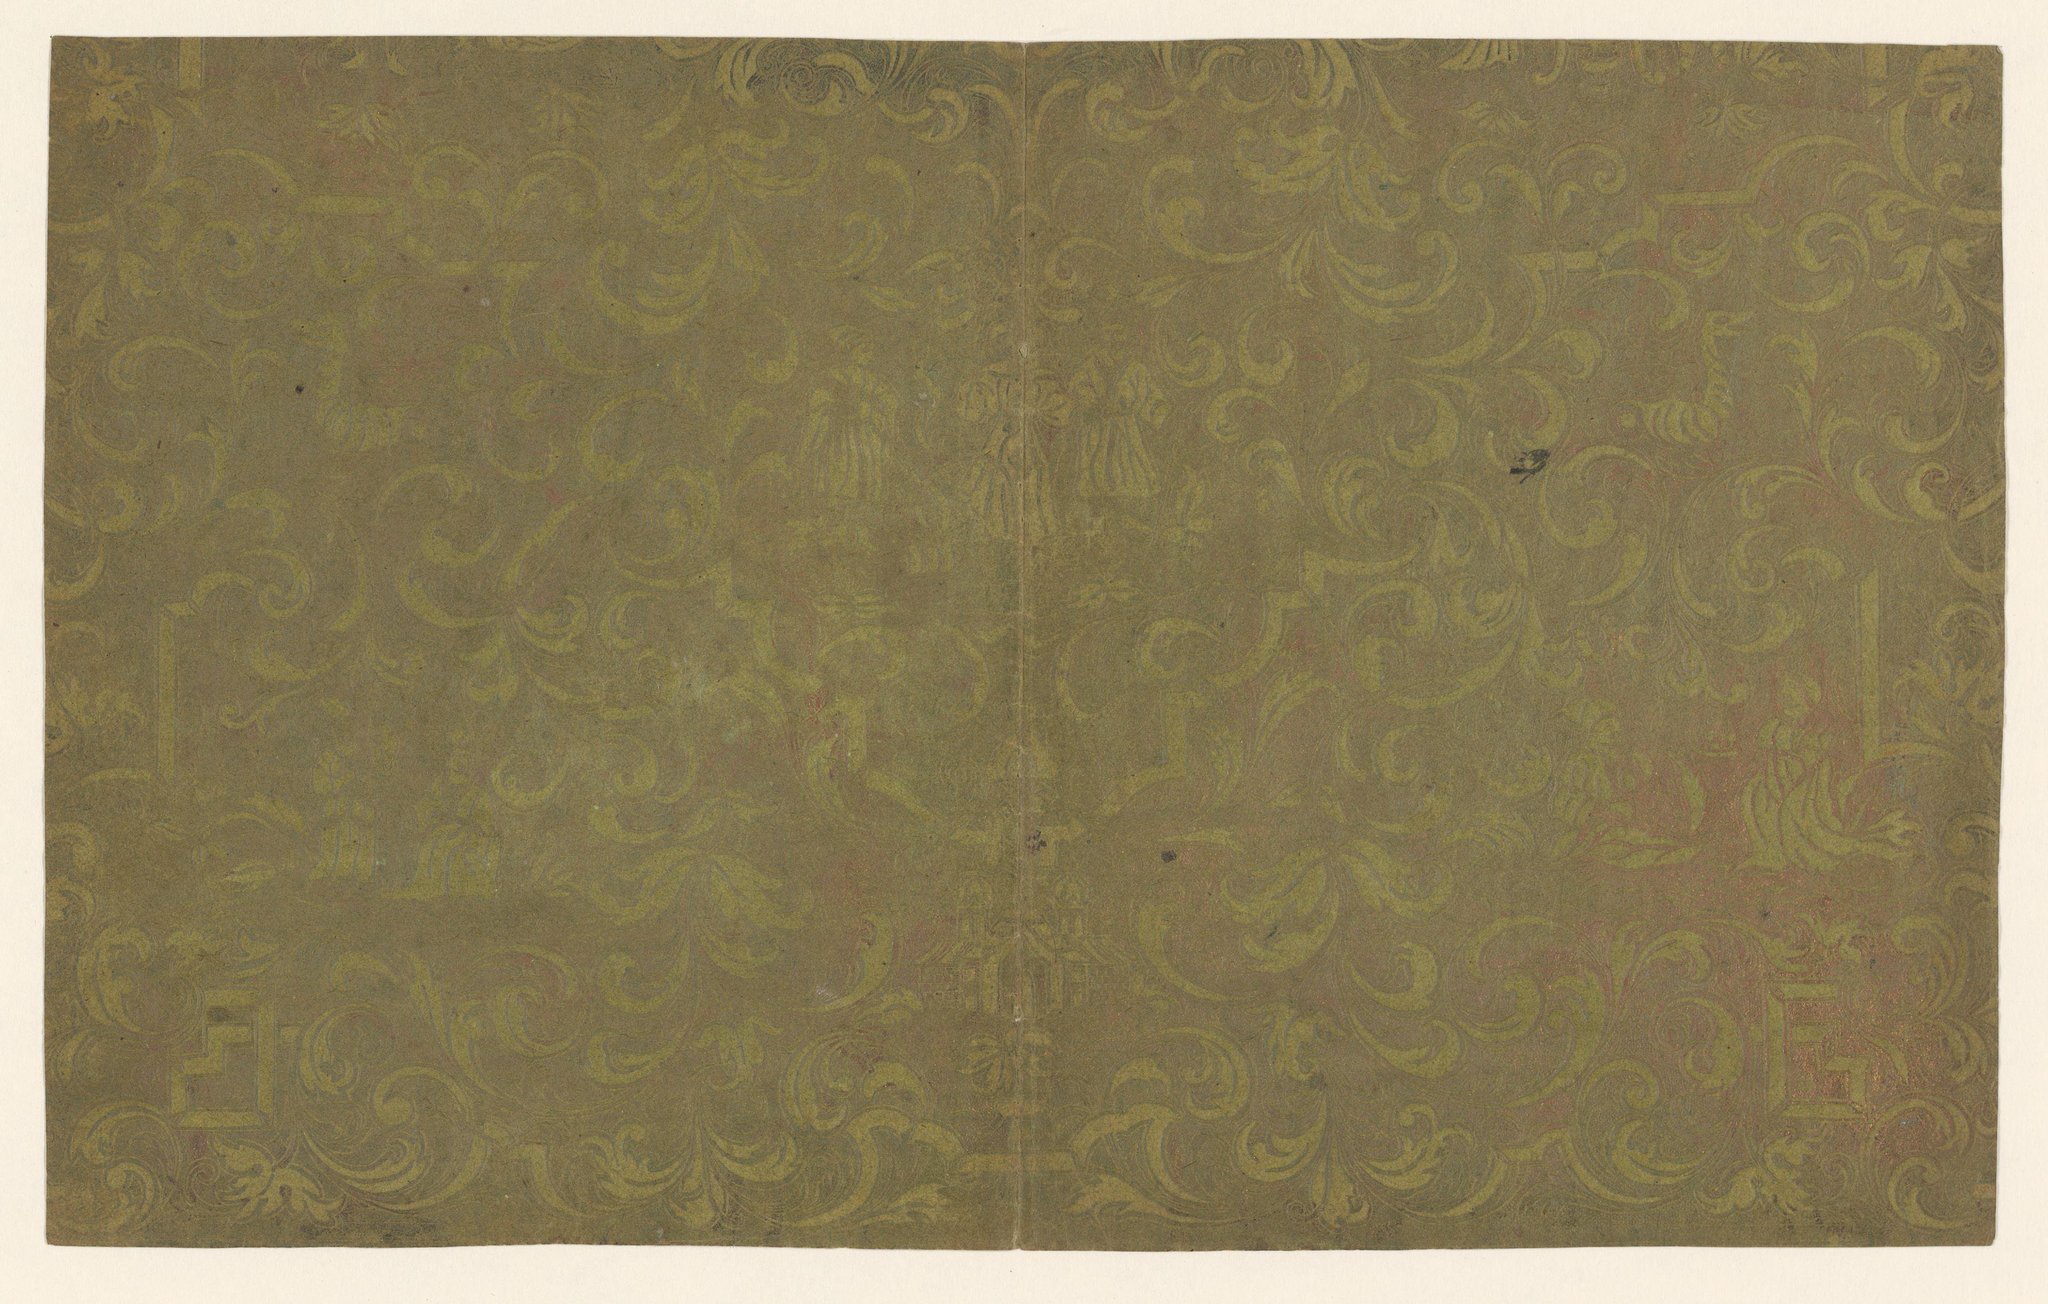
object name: wrapper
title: Blad met staande en knielende figuren tussen ranken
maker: Anonymous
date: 1743-1783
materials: gold leaf, paint, paper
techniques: relief print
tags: anthropomorphic ornament, ornament derived from plant forms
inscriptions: annotation: ‘1763’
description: Blad met meerdere groepen staande en knielende figuren tussen ranken en bandwerk. In het midden onderaan een kerk of kasteel met twee torens. Gebruikt als omslag voor een publicatie uit 1763.